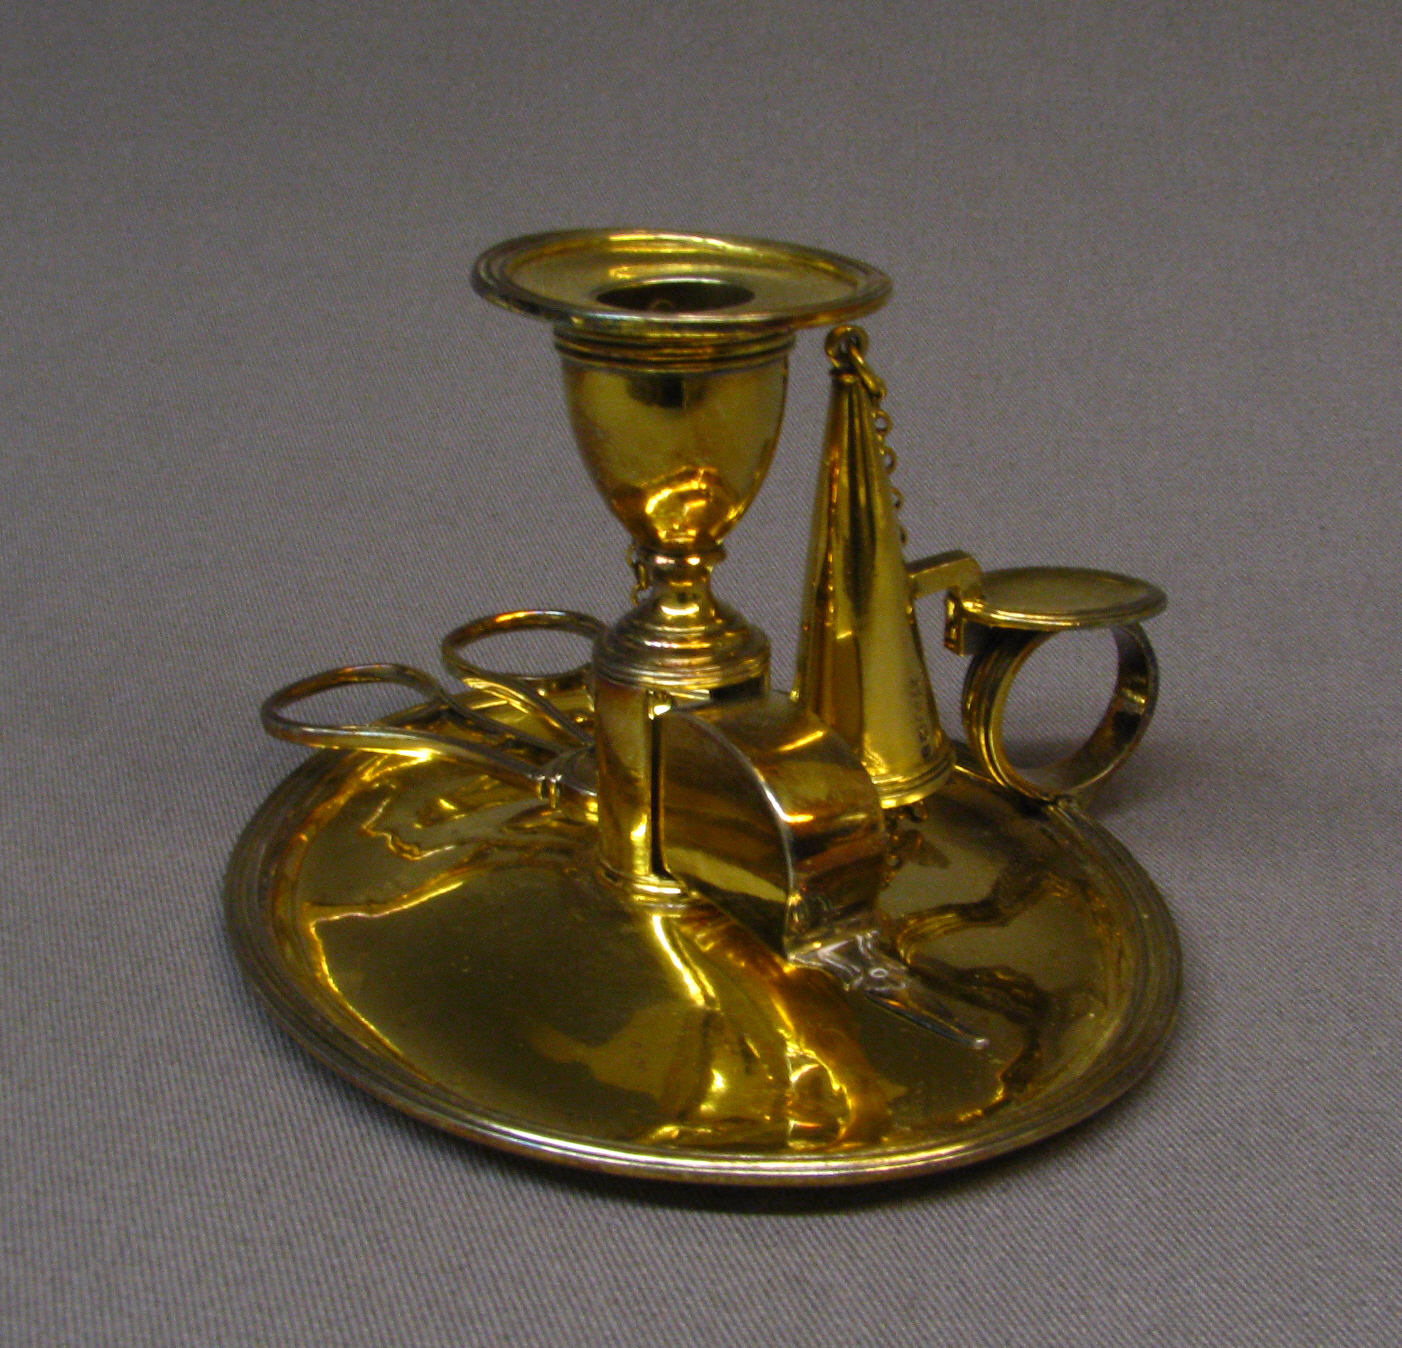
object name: chamber candlestick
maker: john emes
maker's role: maker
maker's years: 1796-1808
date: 1801-1802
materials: silver gilt